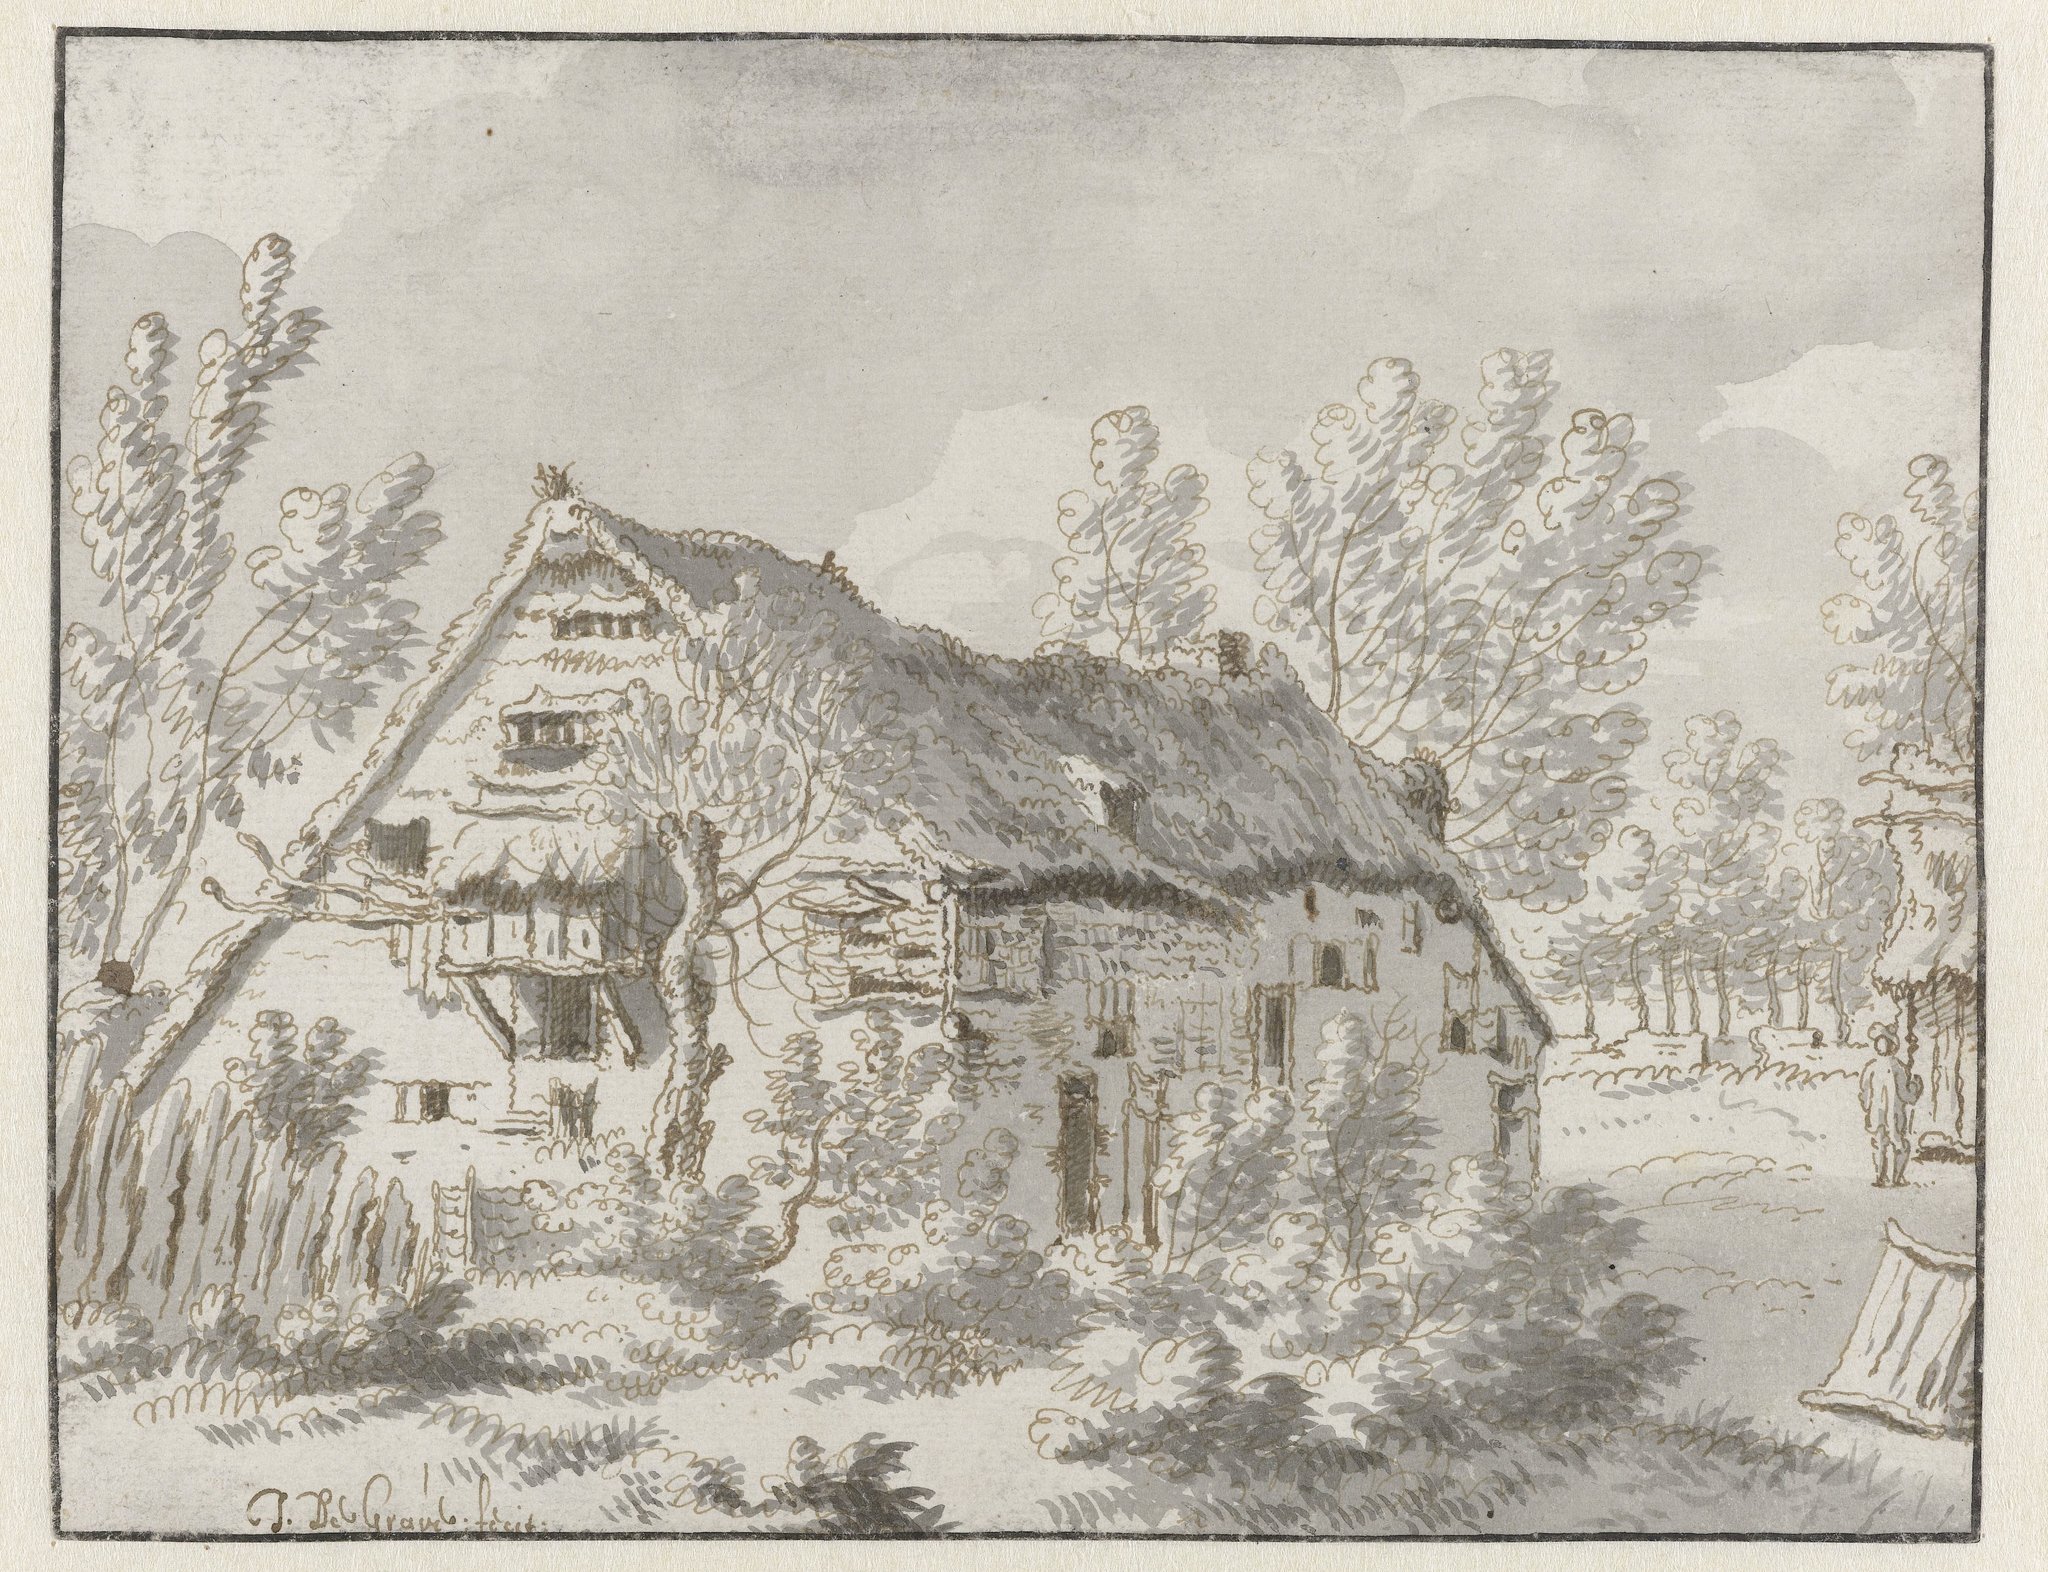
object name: drawing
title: View of a Farmhouse near Mechelen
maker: josua de grave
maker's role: draughtsman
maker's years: 1645-1712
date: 1674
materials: ink, paper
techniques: brush, pen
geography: mechelen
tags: farm (building)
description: Landschap te Berghen bij Mechelen, of het plaatsje Battel, ten westen van Mechelen.